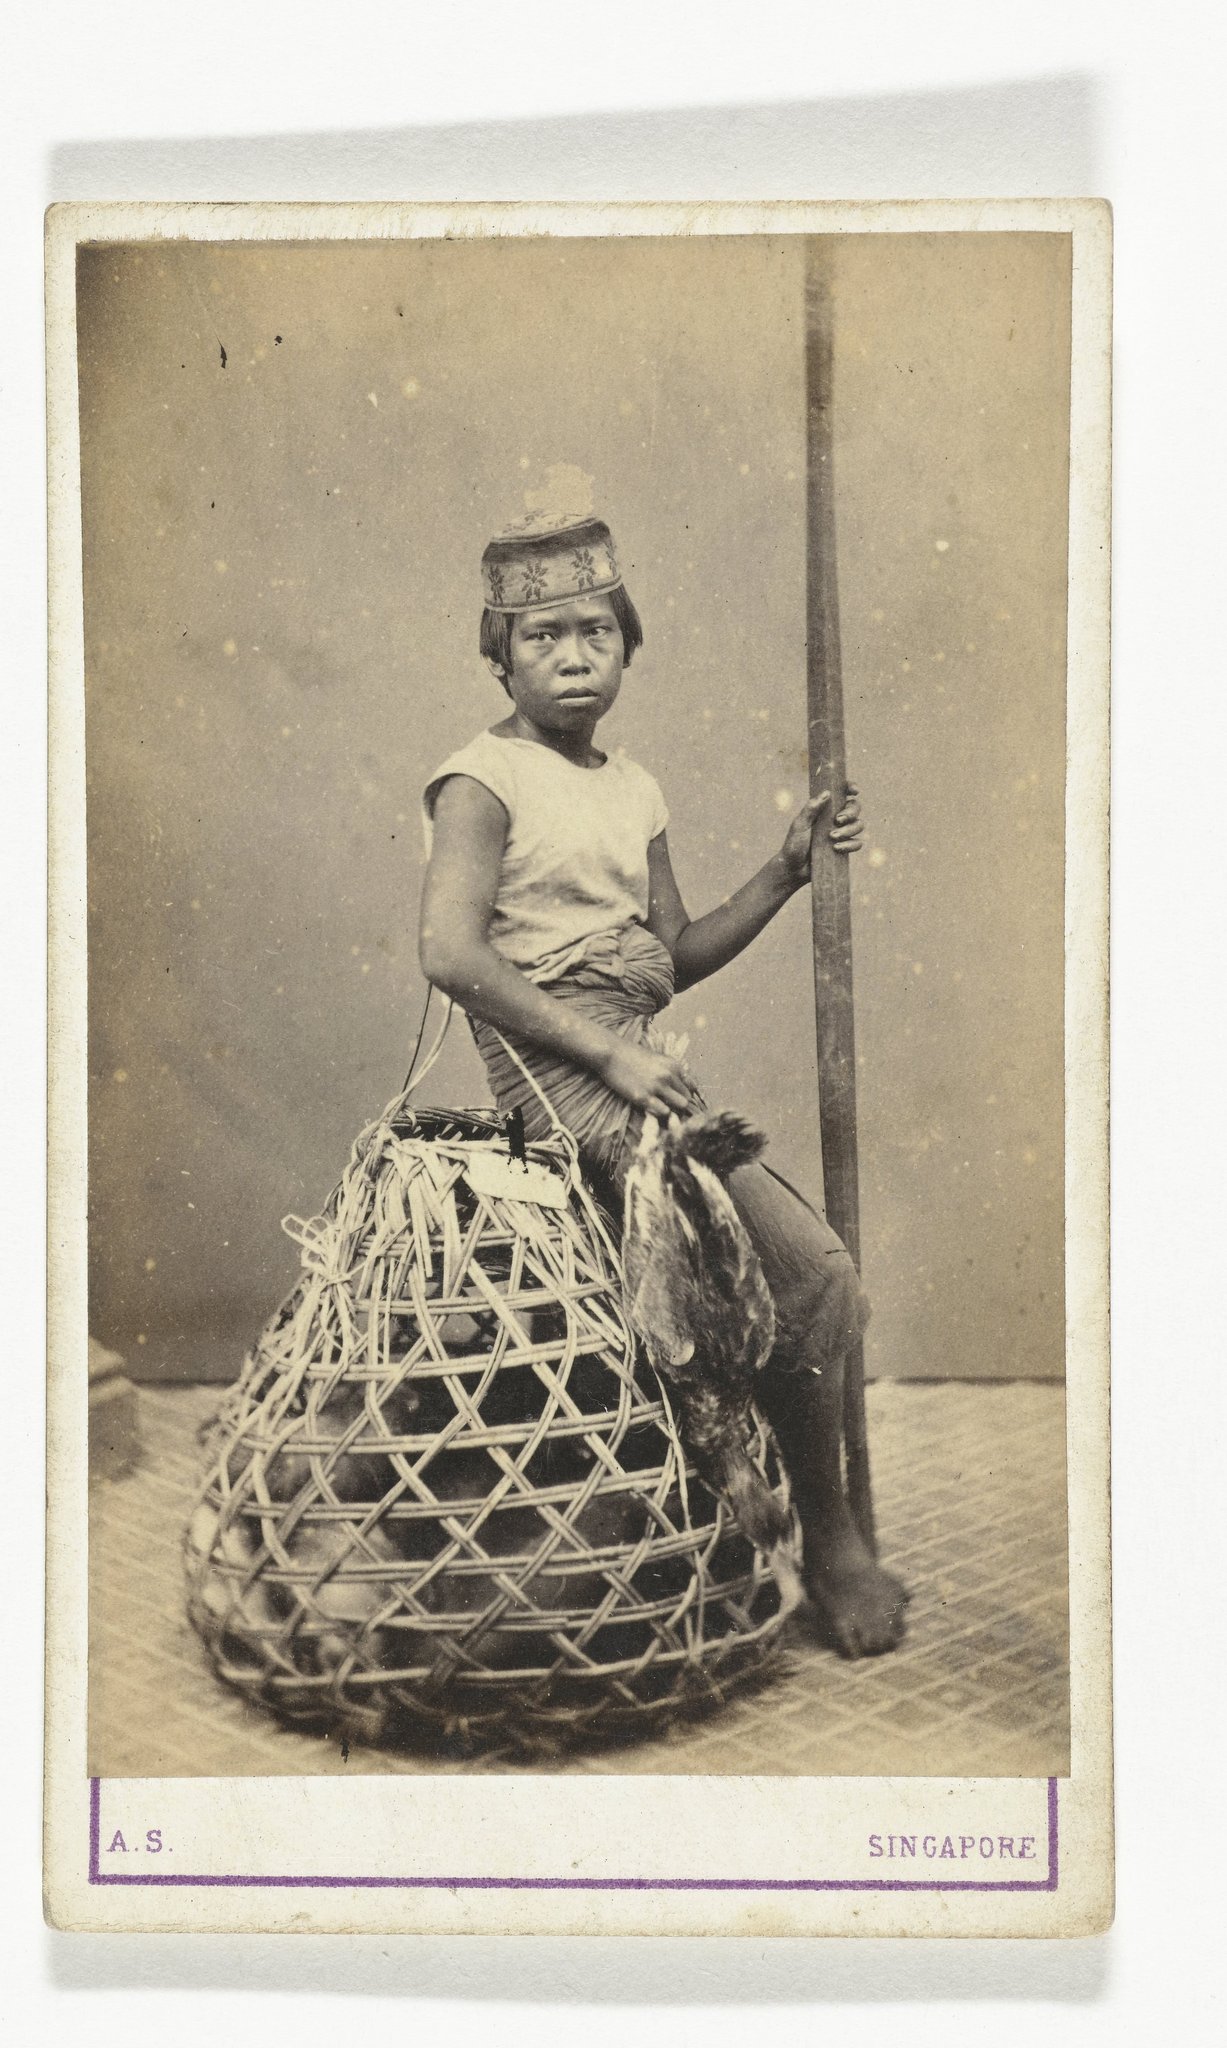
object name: carte de visite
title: Portret van een onbekende jongen met een mand met eenden en ander gevogelte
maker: august sachtler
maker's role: fotograaf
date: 1870-1900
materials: cardboard, paper, photographic support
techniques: albumen print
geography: singapore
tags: merchant, salesman, historical persons not known by name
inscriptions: monogram: ‘A.S.’, inscription: ‘Singapore’, signature: ‘A. Sachtler photographer Singapore’, title: ‘Kippen koopman Singapore’